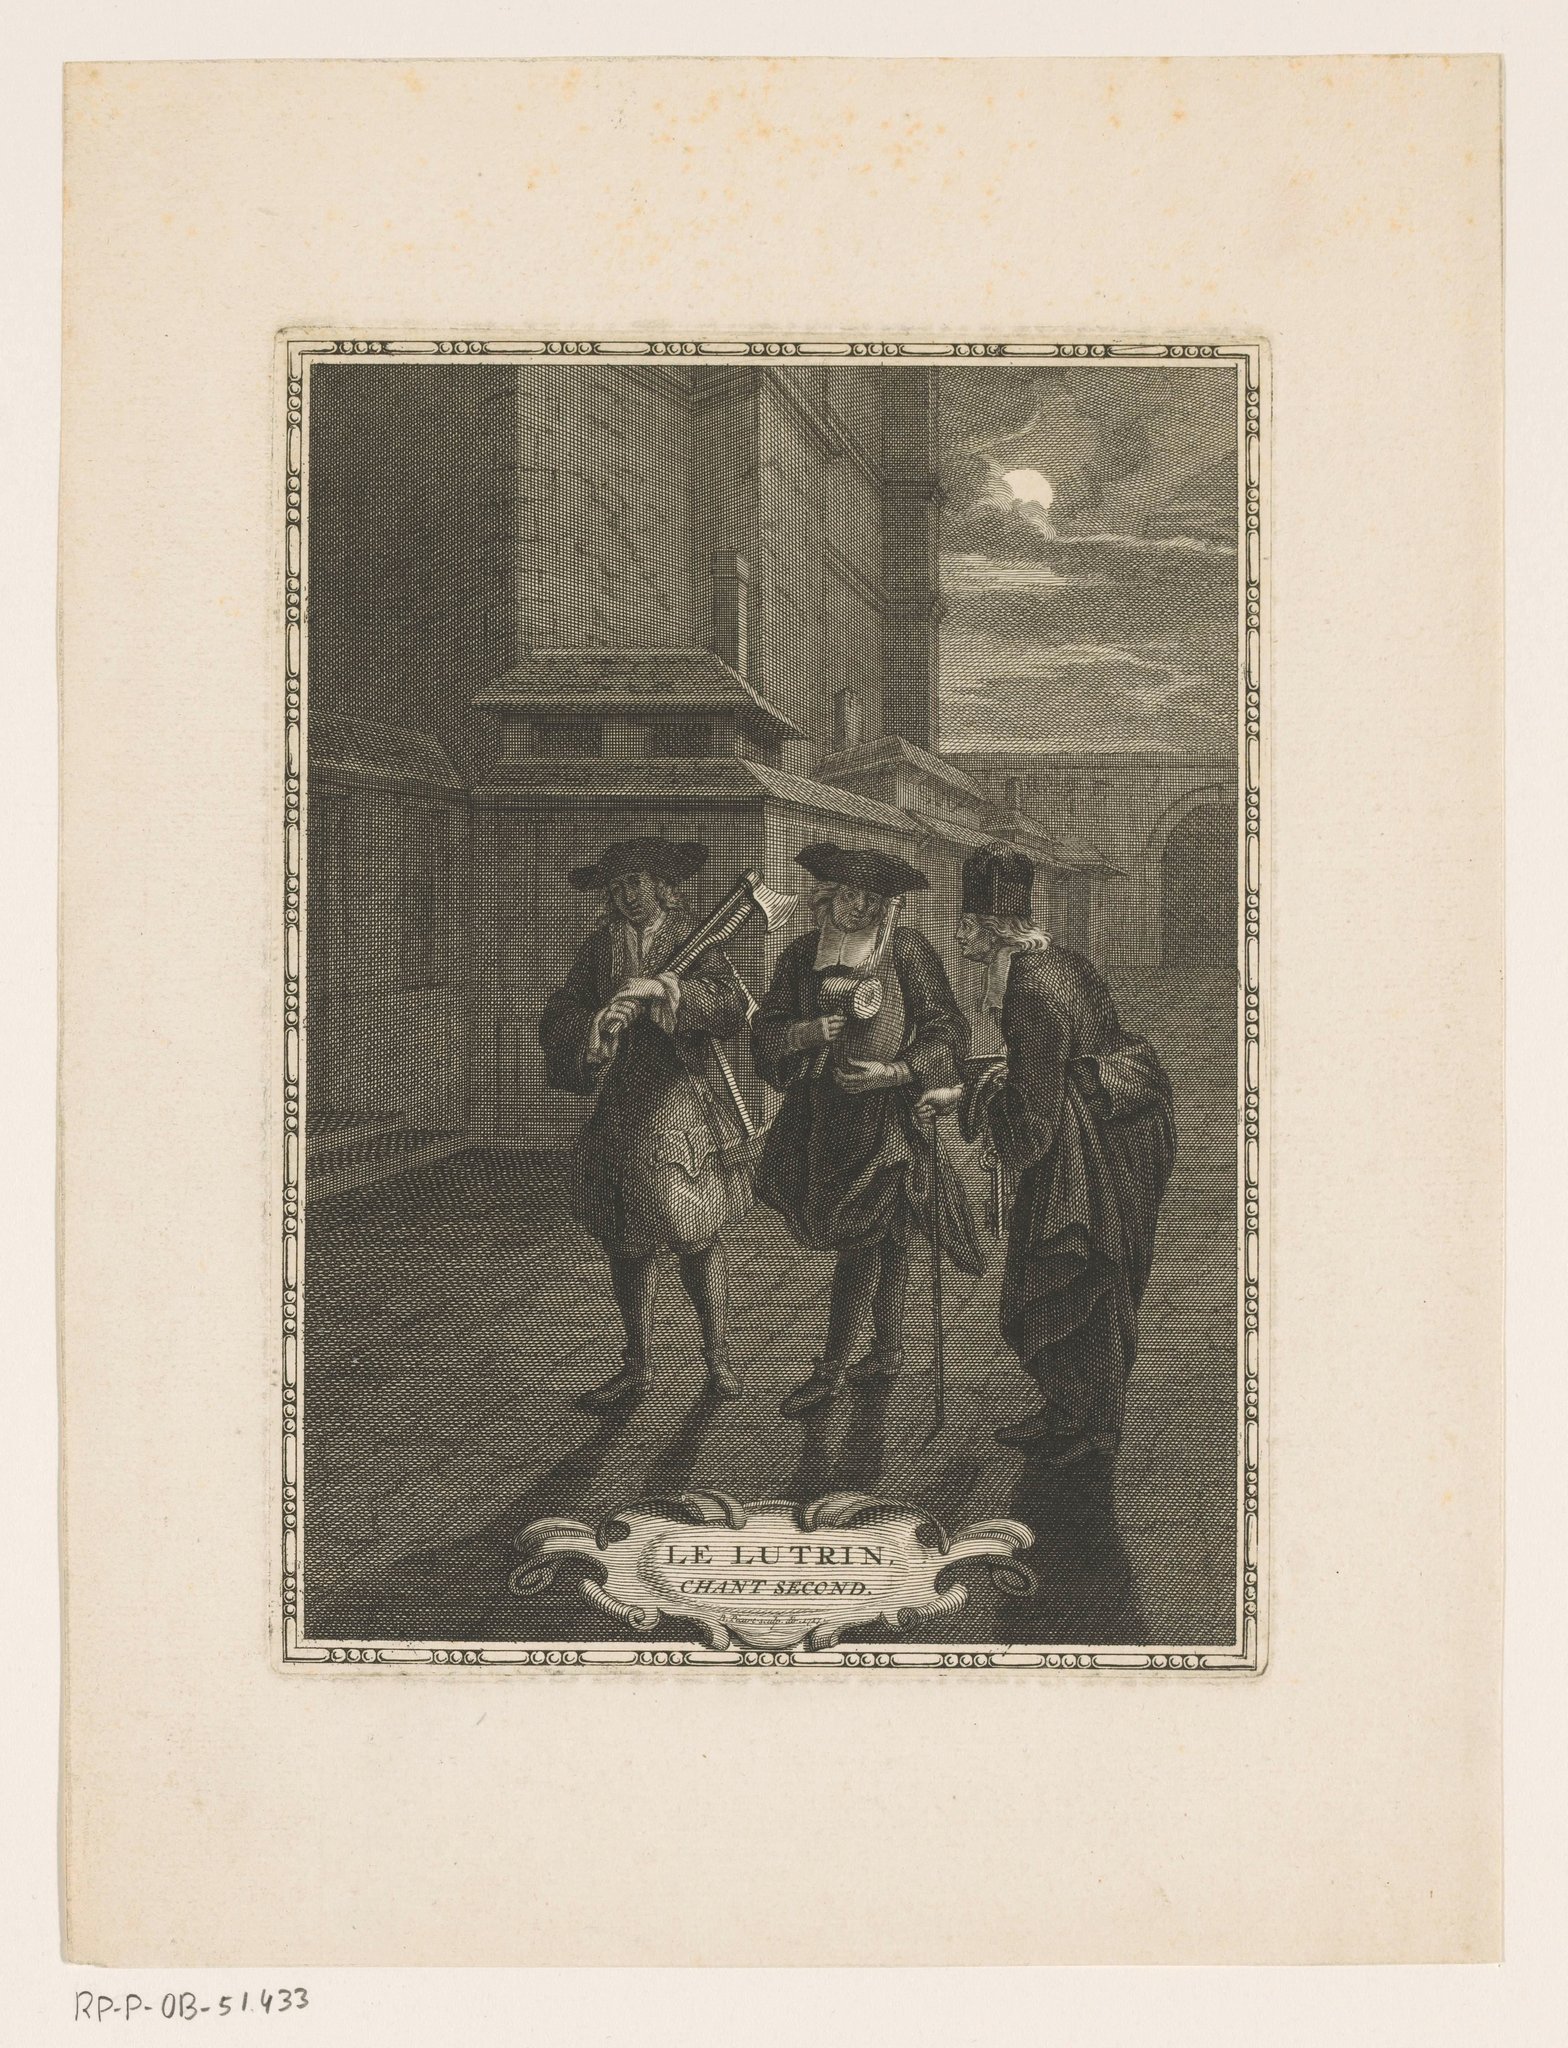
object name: print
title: Le Lutrin. Chant Second.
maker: bernard picart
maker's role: draughtsman, print maker, publisher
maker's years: 1673-1733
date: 1717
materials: paper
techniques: engraving, etching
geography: amsterdam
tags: tools, implements of sculptor: mallet, walking-stick, staff, tools, aids, implements ~ crafts and industries: axe, night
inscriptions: collector's mark: Lugt 240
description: Prent ook gebruikt als illustratie in: Boileau, Nicolas. Oeuvres de Nicolas Boileau Despréaux. Deel I, voorafgaand aan p. 343. Amsterdam: David Mortier, 1718.